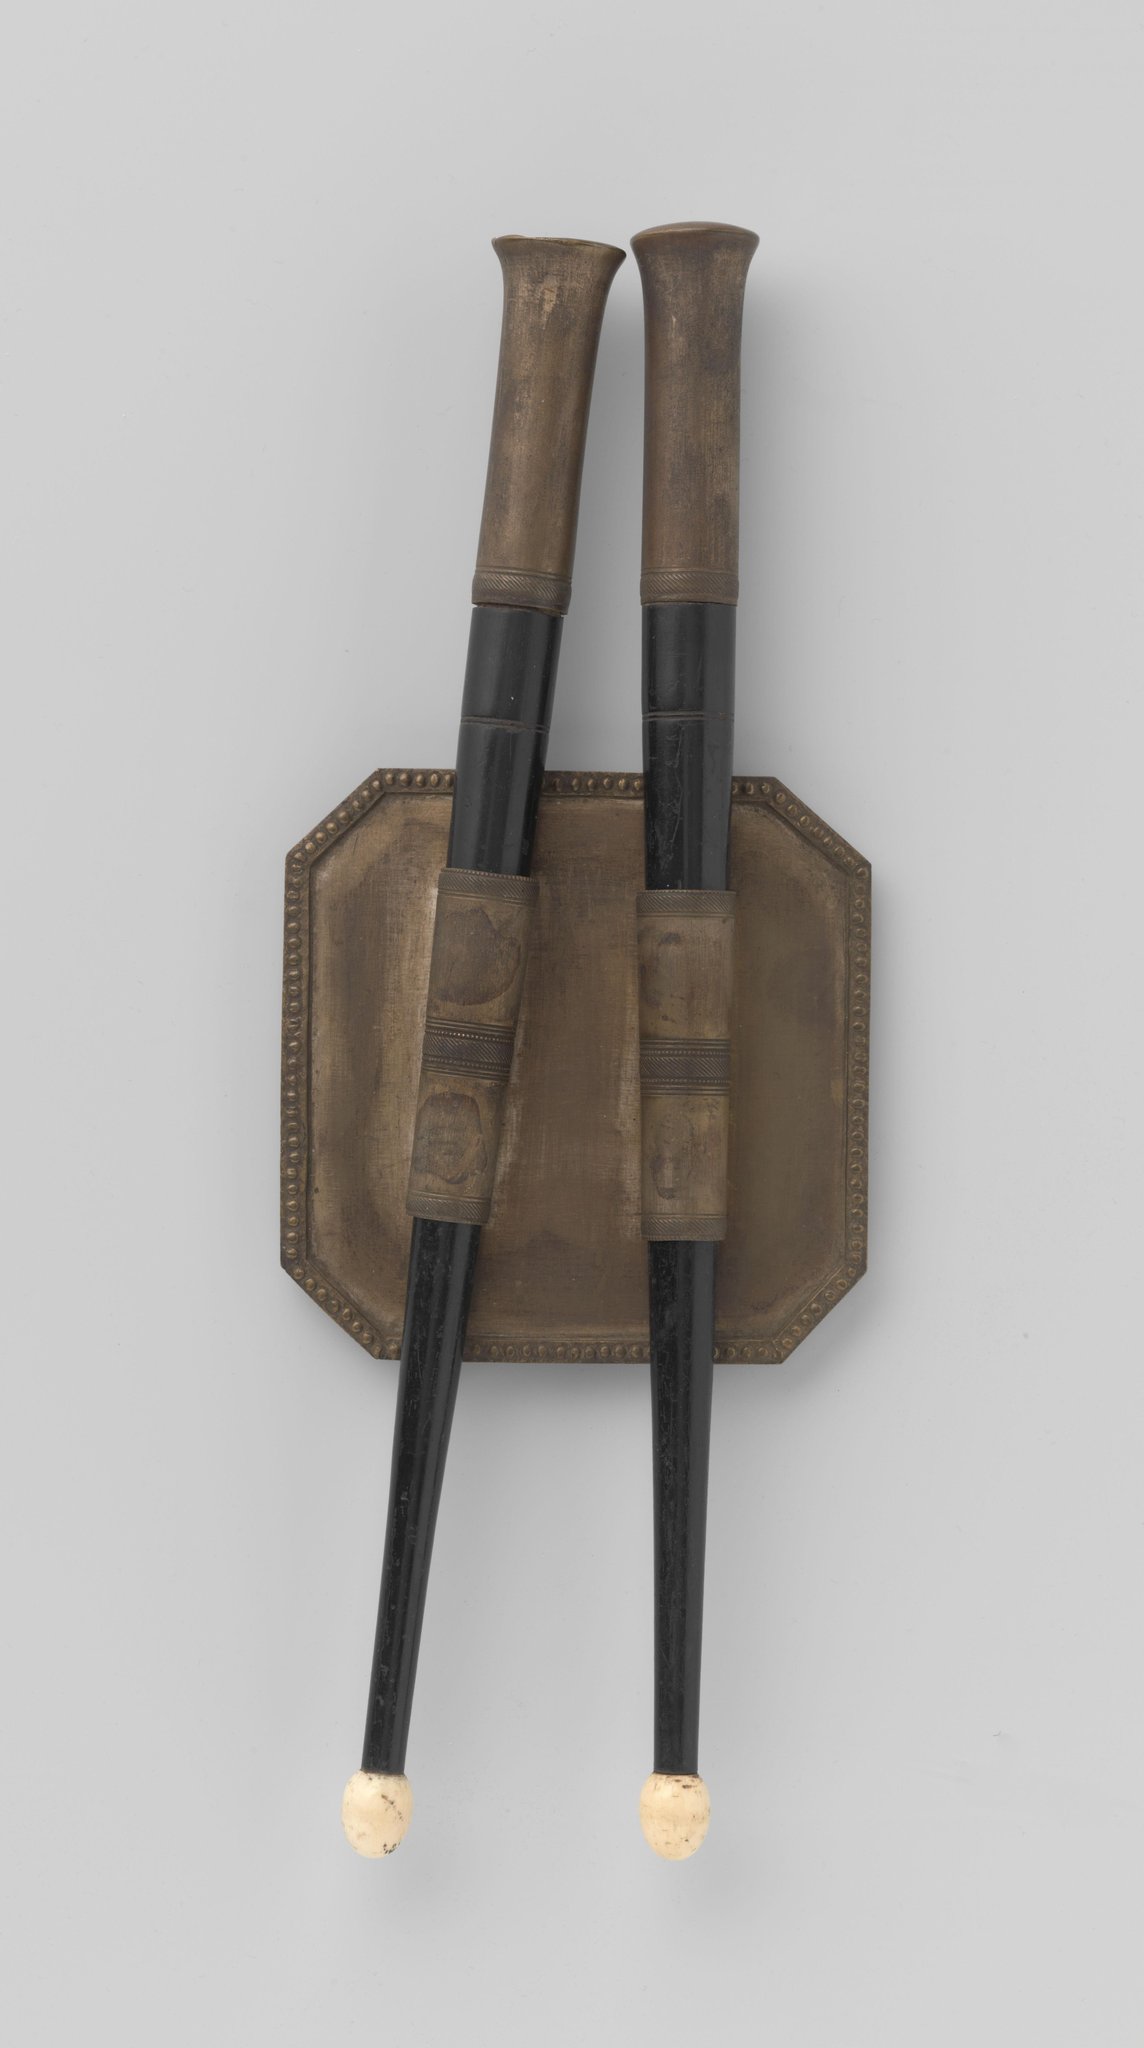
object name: element of musical instrument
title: Drumsticks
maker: Anonymous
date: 1817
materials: wood, ivory, plate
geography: netherlands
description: Ebbenhouten voor tamboer-majoor tromstok met ivoren knop. Stok bezet met bussen van pleet.